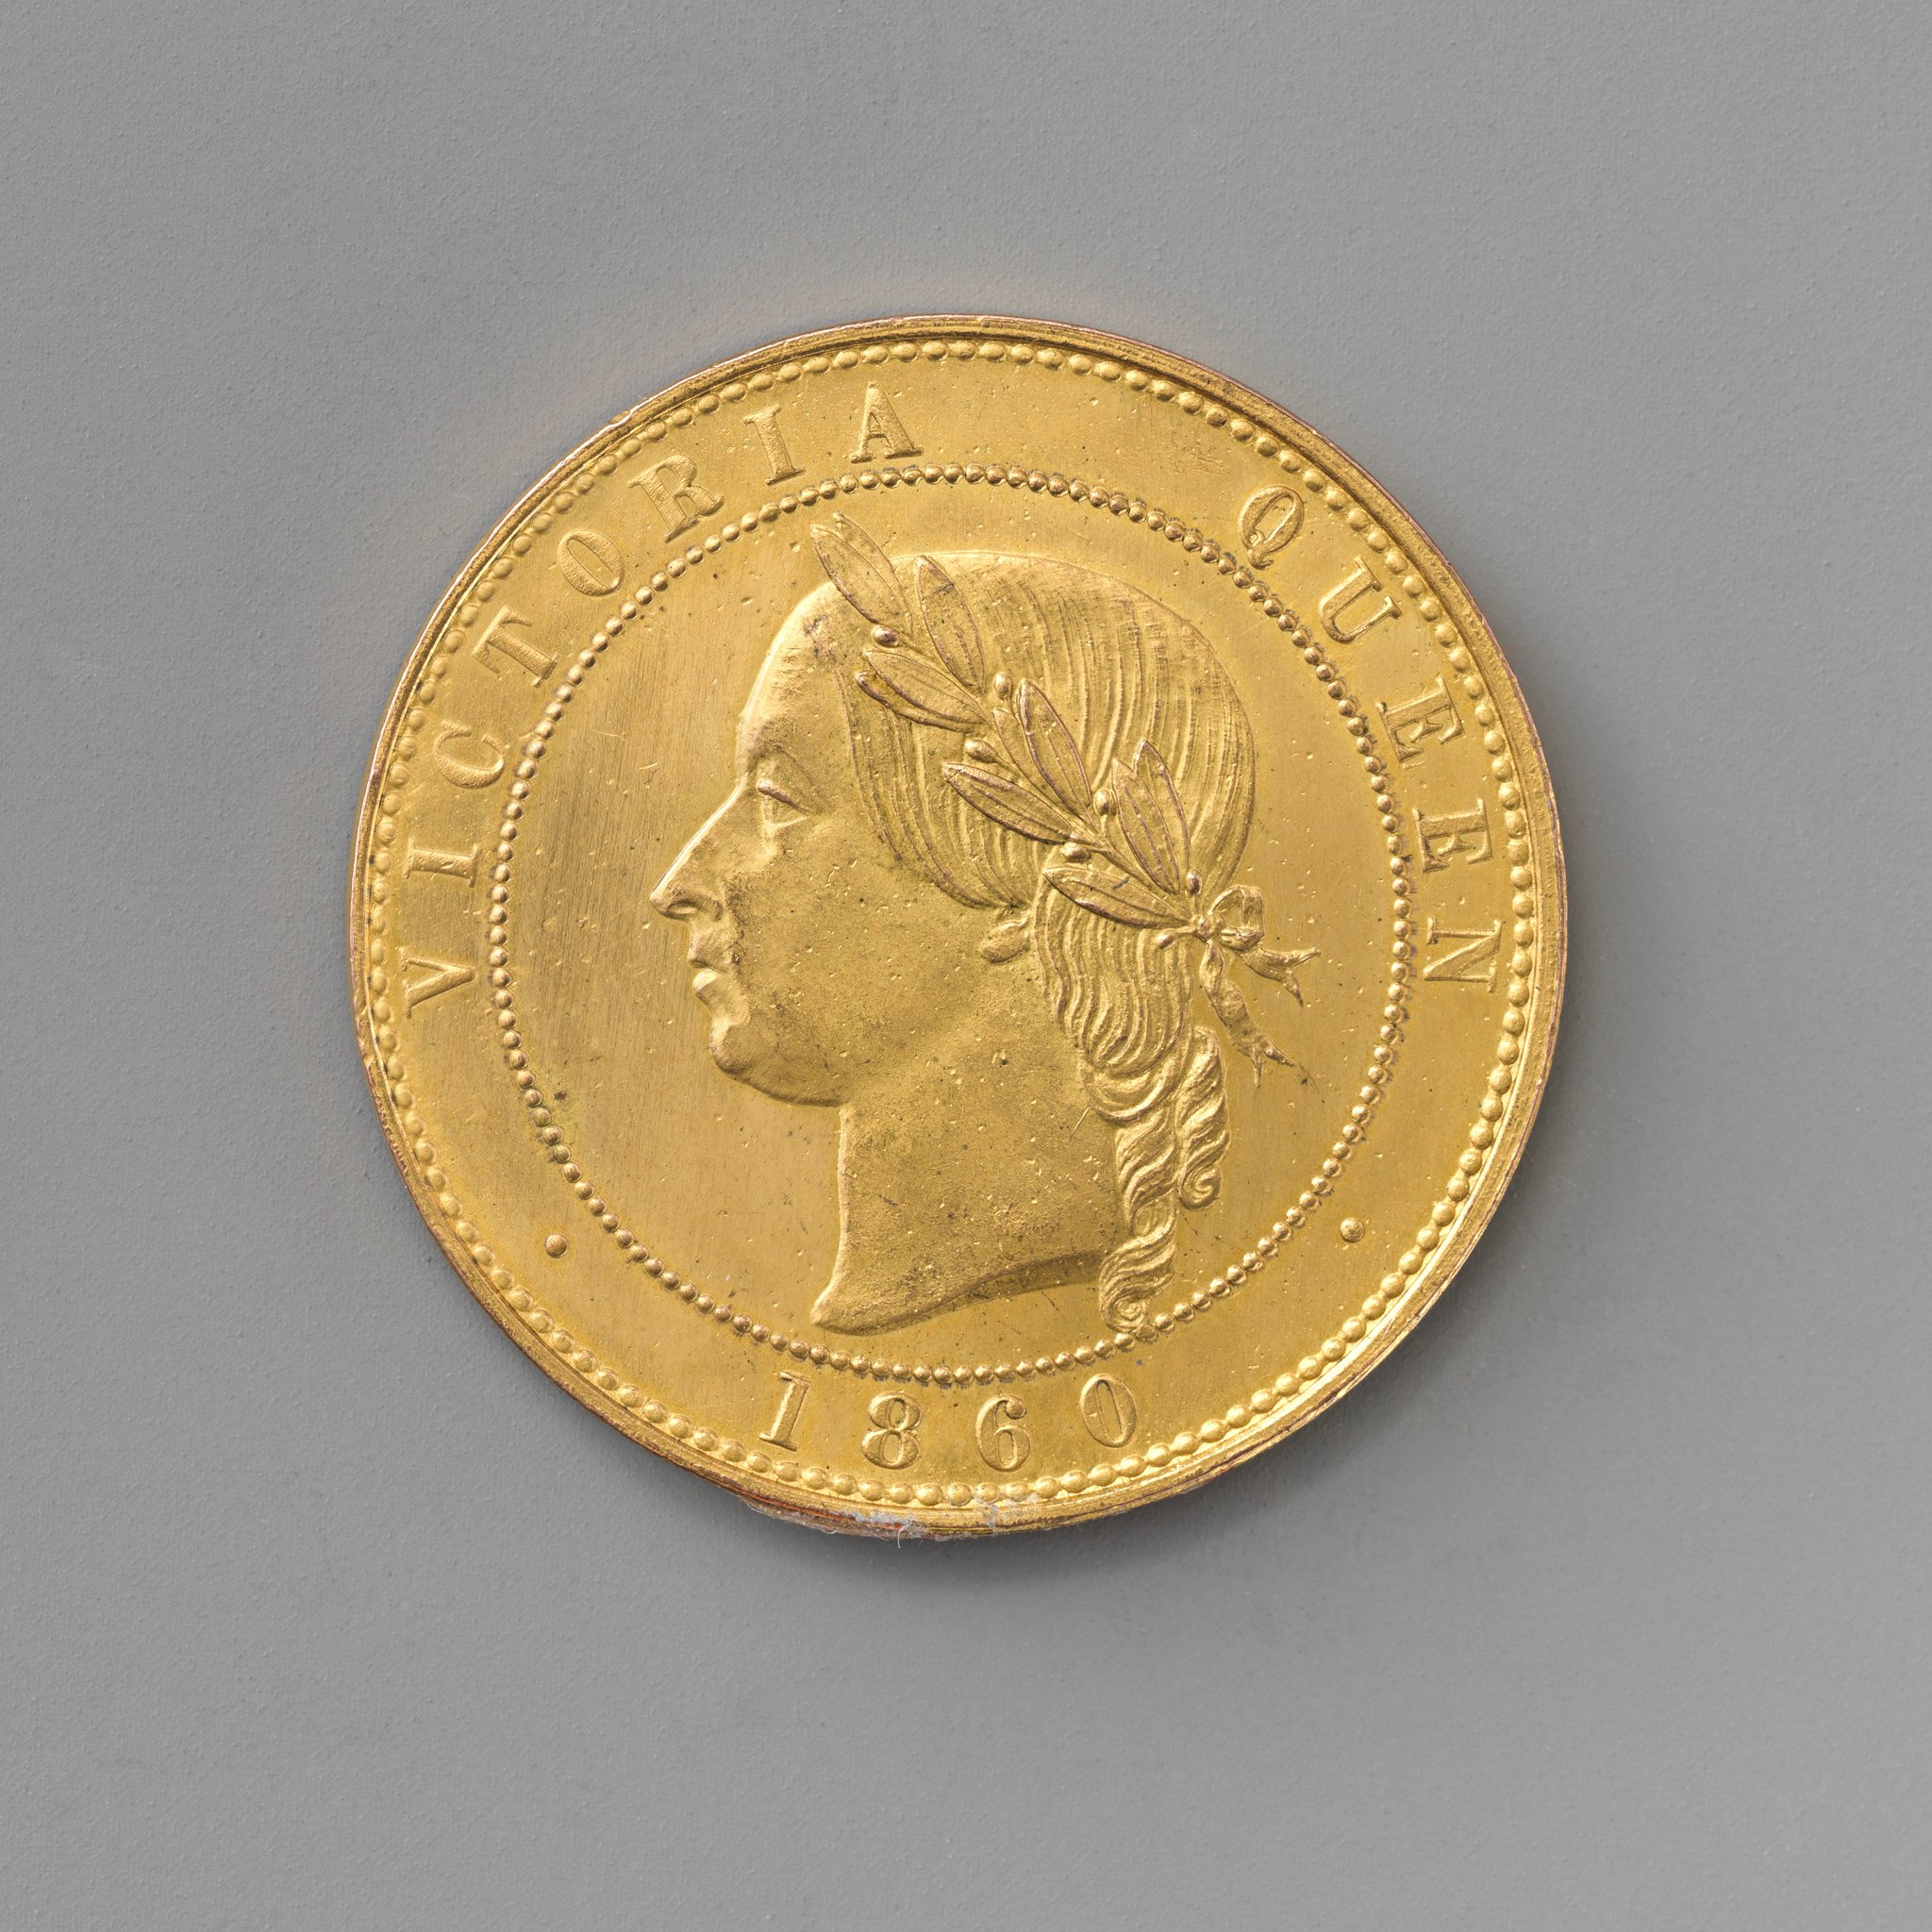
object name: penny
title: Pattern penny of Queen Victoria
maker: joseph moore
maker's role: artist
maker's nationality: british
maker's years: 1817-1892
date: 1860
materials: copper gilt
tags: profiles,queen victoria